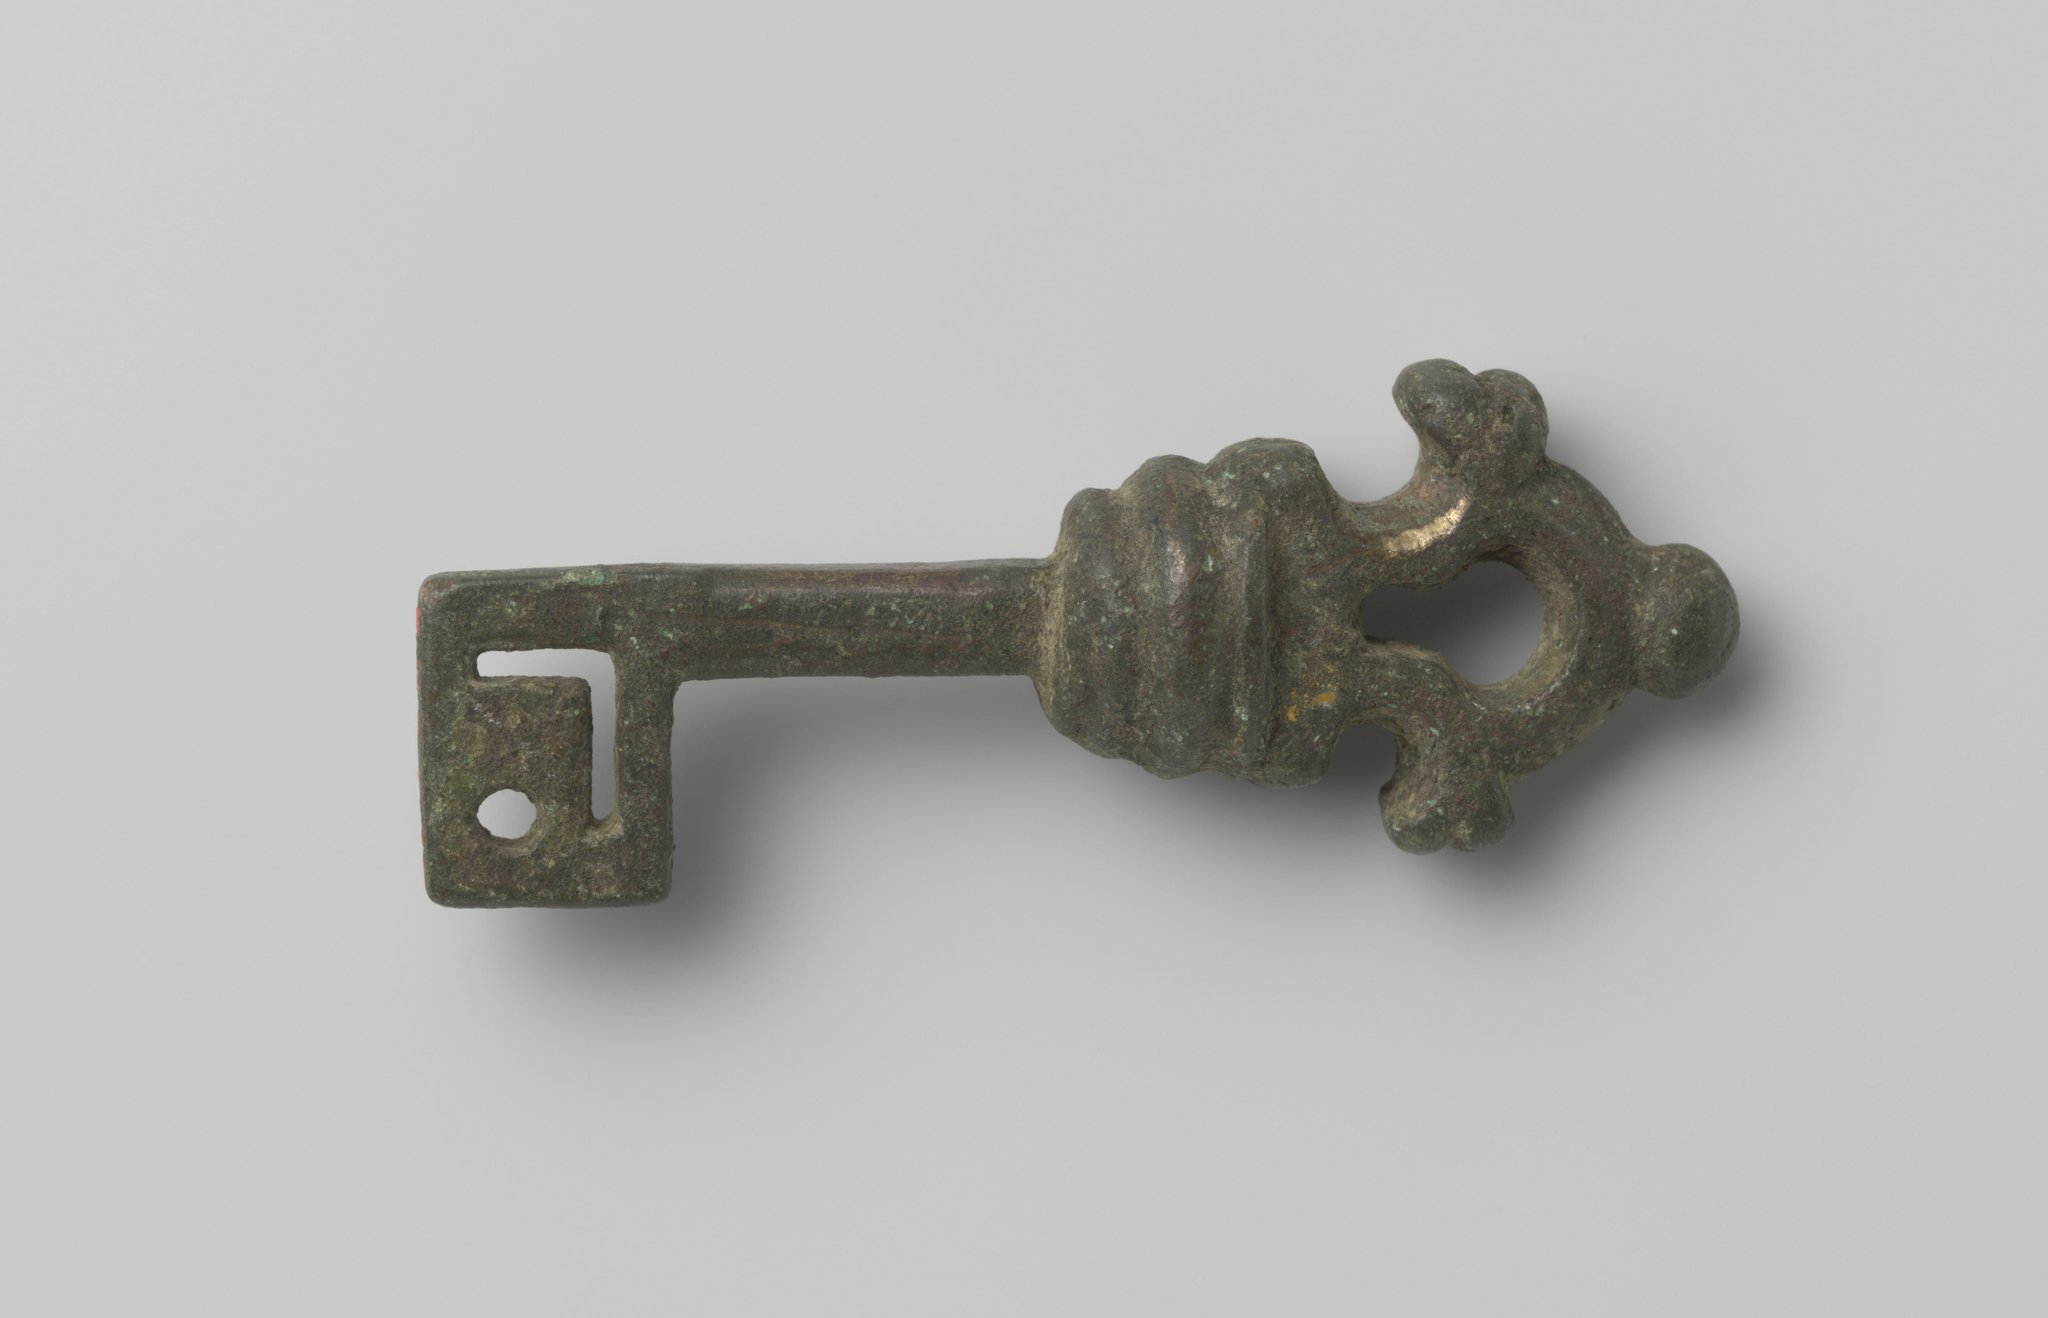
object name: key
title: 39 keys from the collection of Emmanuel Vita Israël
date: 1400-1950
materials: bronze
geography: rome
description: The Amsterdam apothecary and art collector Emmanuel Vita Israël. He donated his collection, comprising keys dating from Roman antiquity to the 19th century, to the Koninklijk Oudheidkundig Genootschap (Royal Antiquarian Society) in 1937. Vita Israël claimed that his key collection had grown more or less by accident: being one of the few collectors of keys, dealers automatically made their way to him.